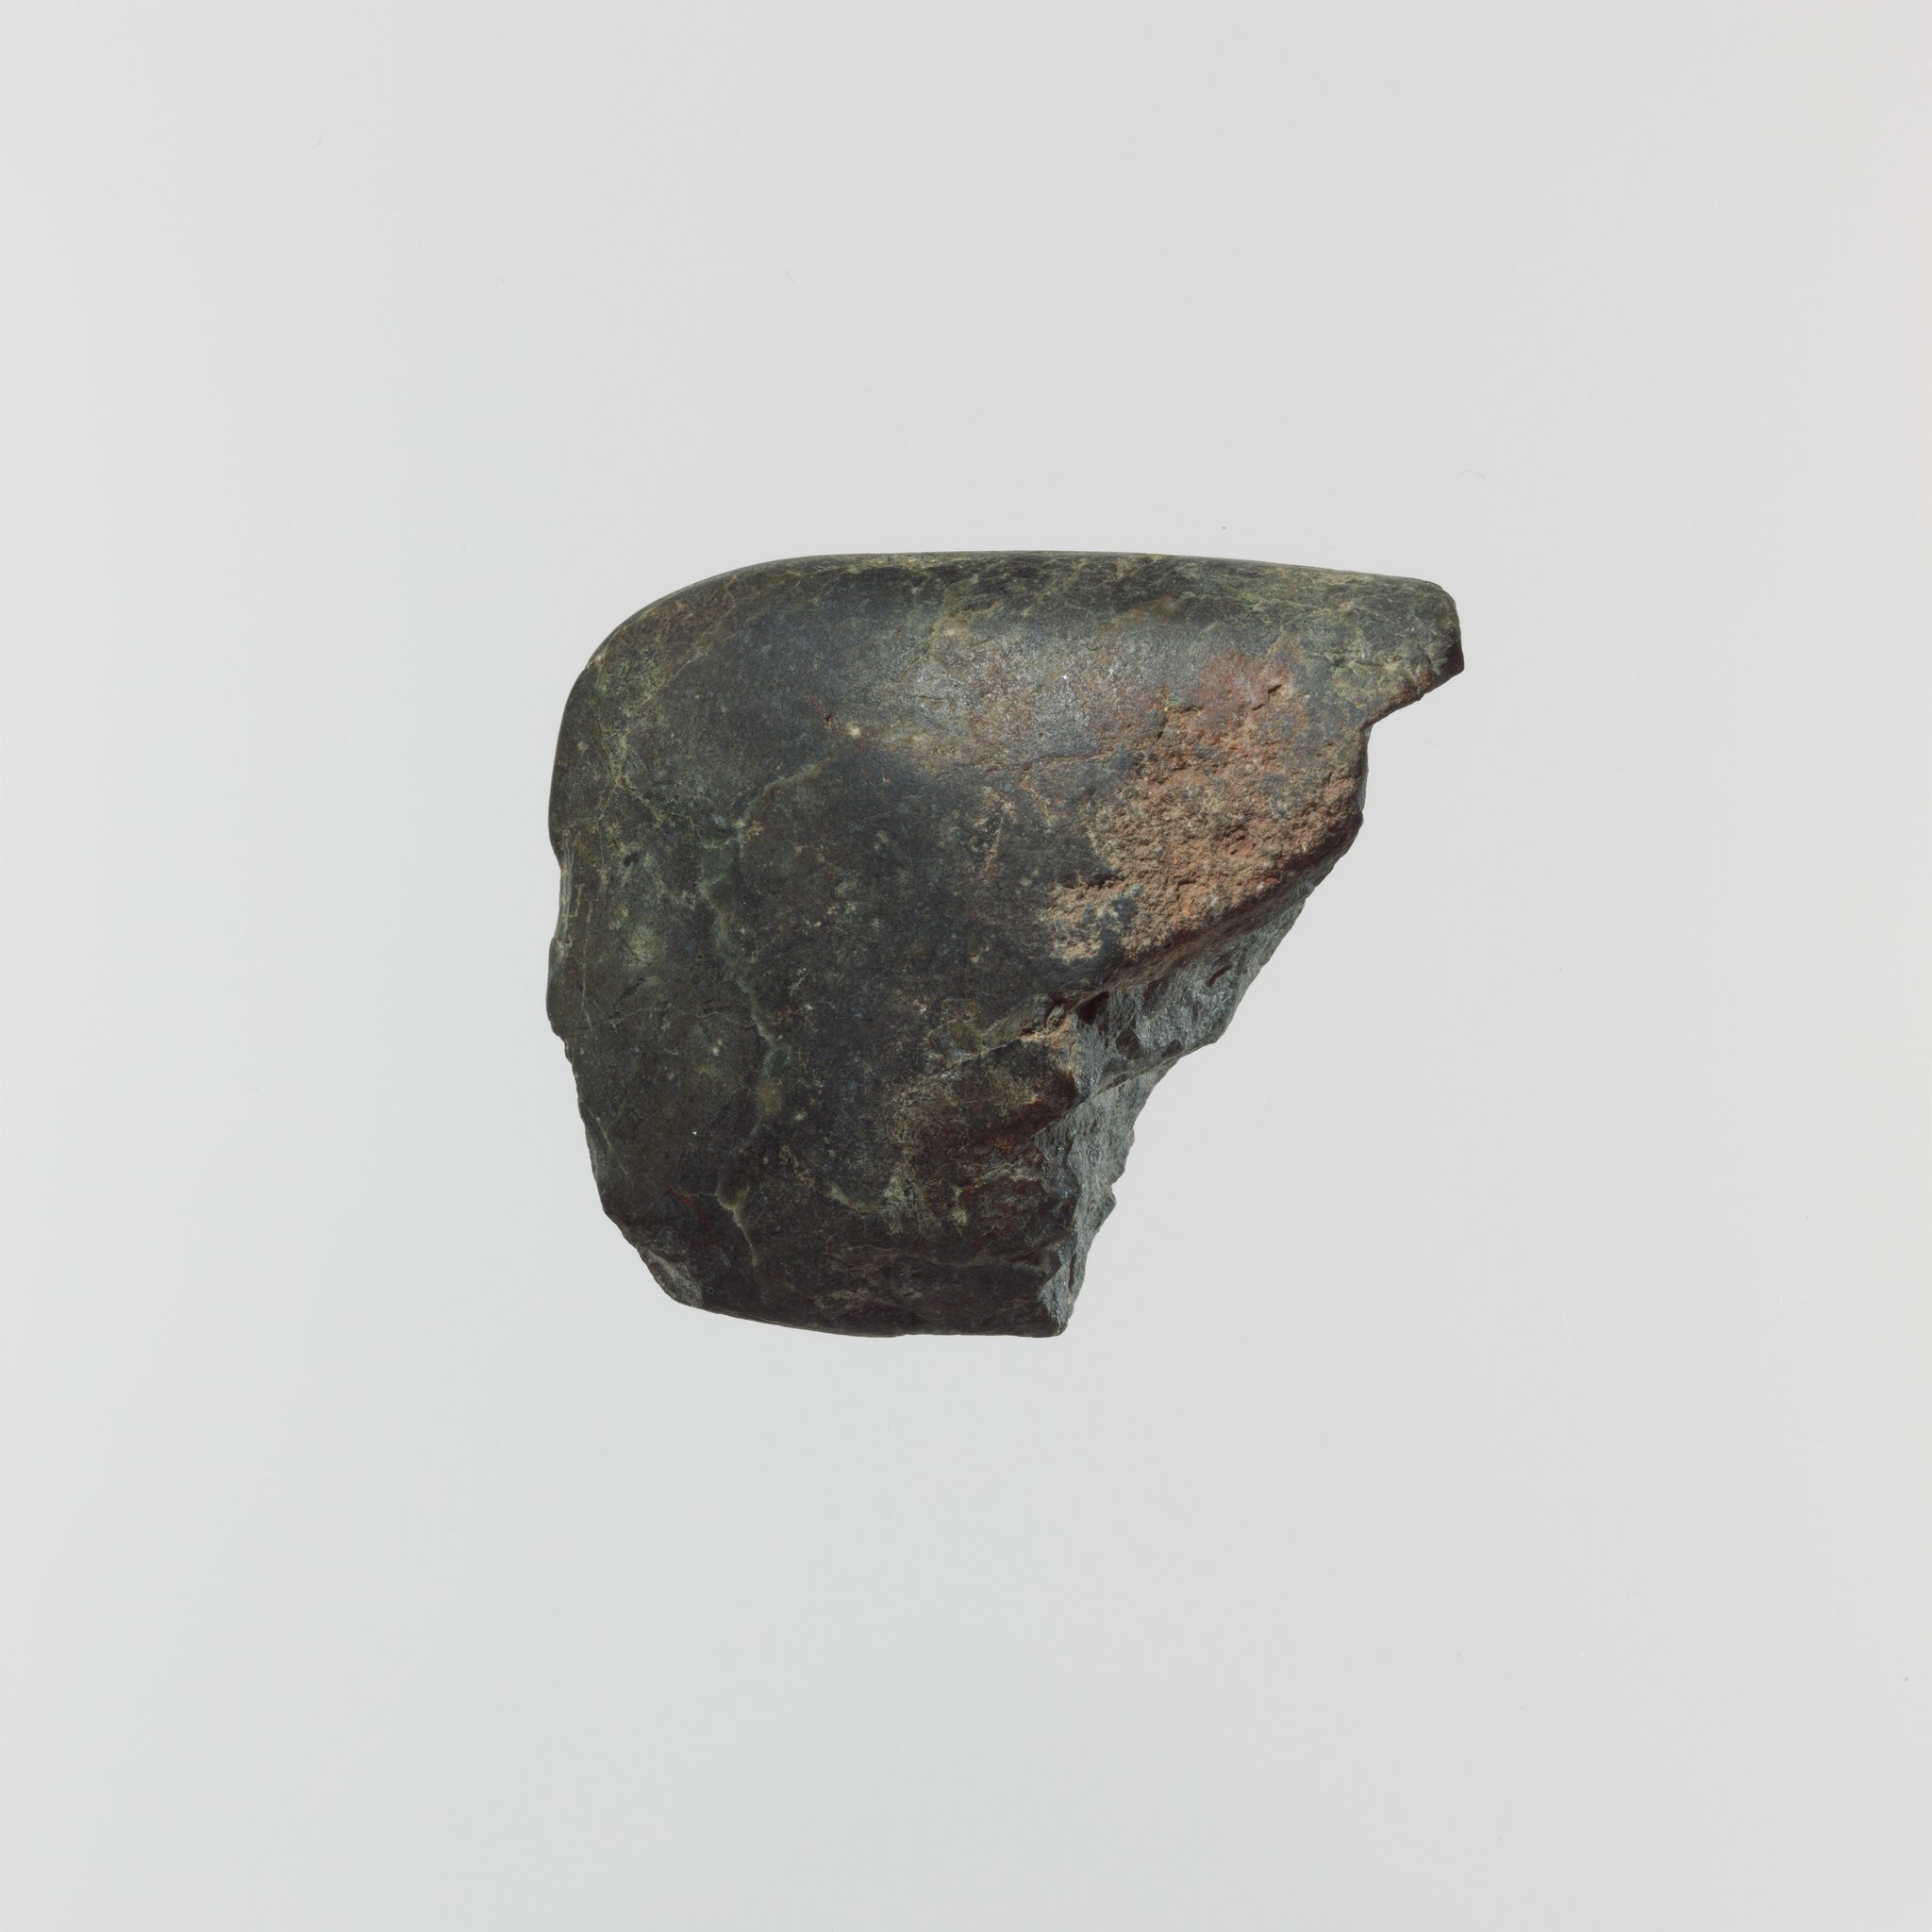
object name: celt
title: Fragmentary stone axe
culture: greek neolithic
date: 5000-2001 BCE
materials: stone